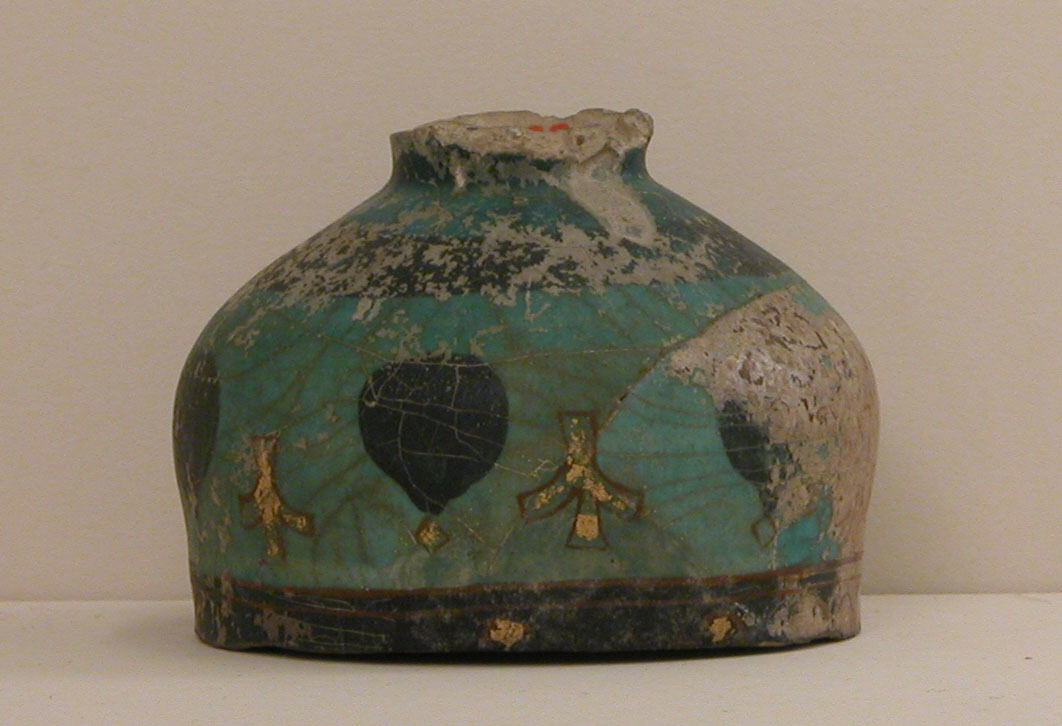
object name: bowl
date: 1201-1300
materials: stonepaste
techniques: gilding, overglaze, painting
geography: iran